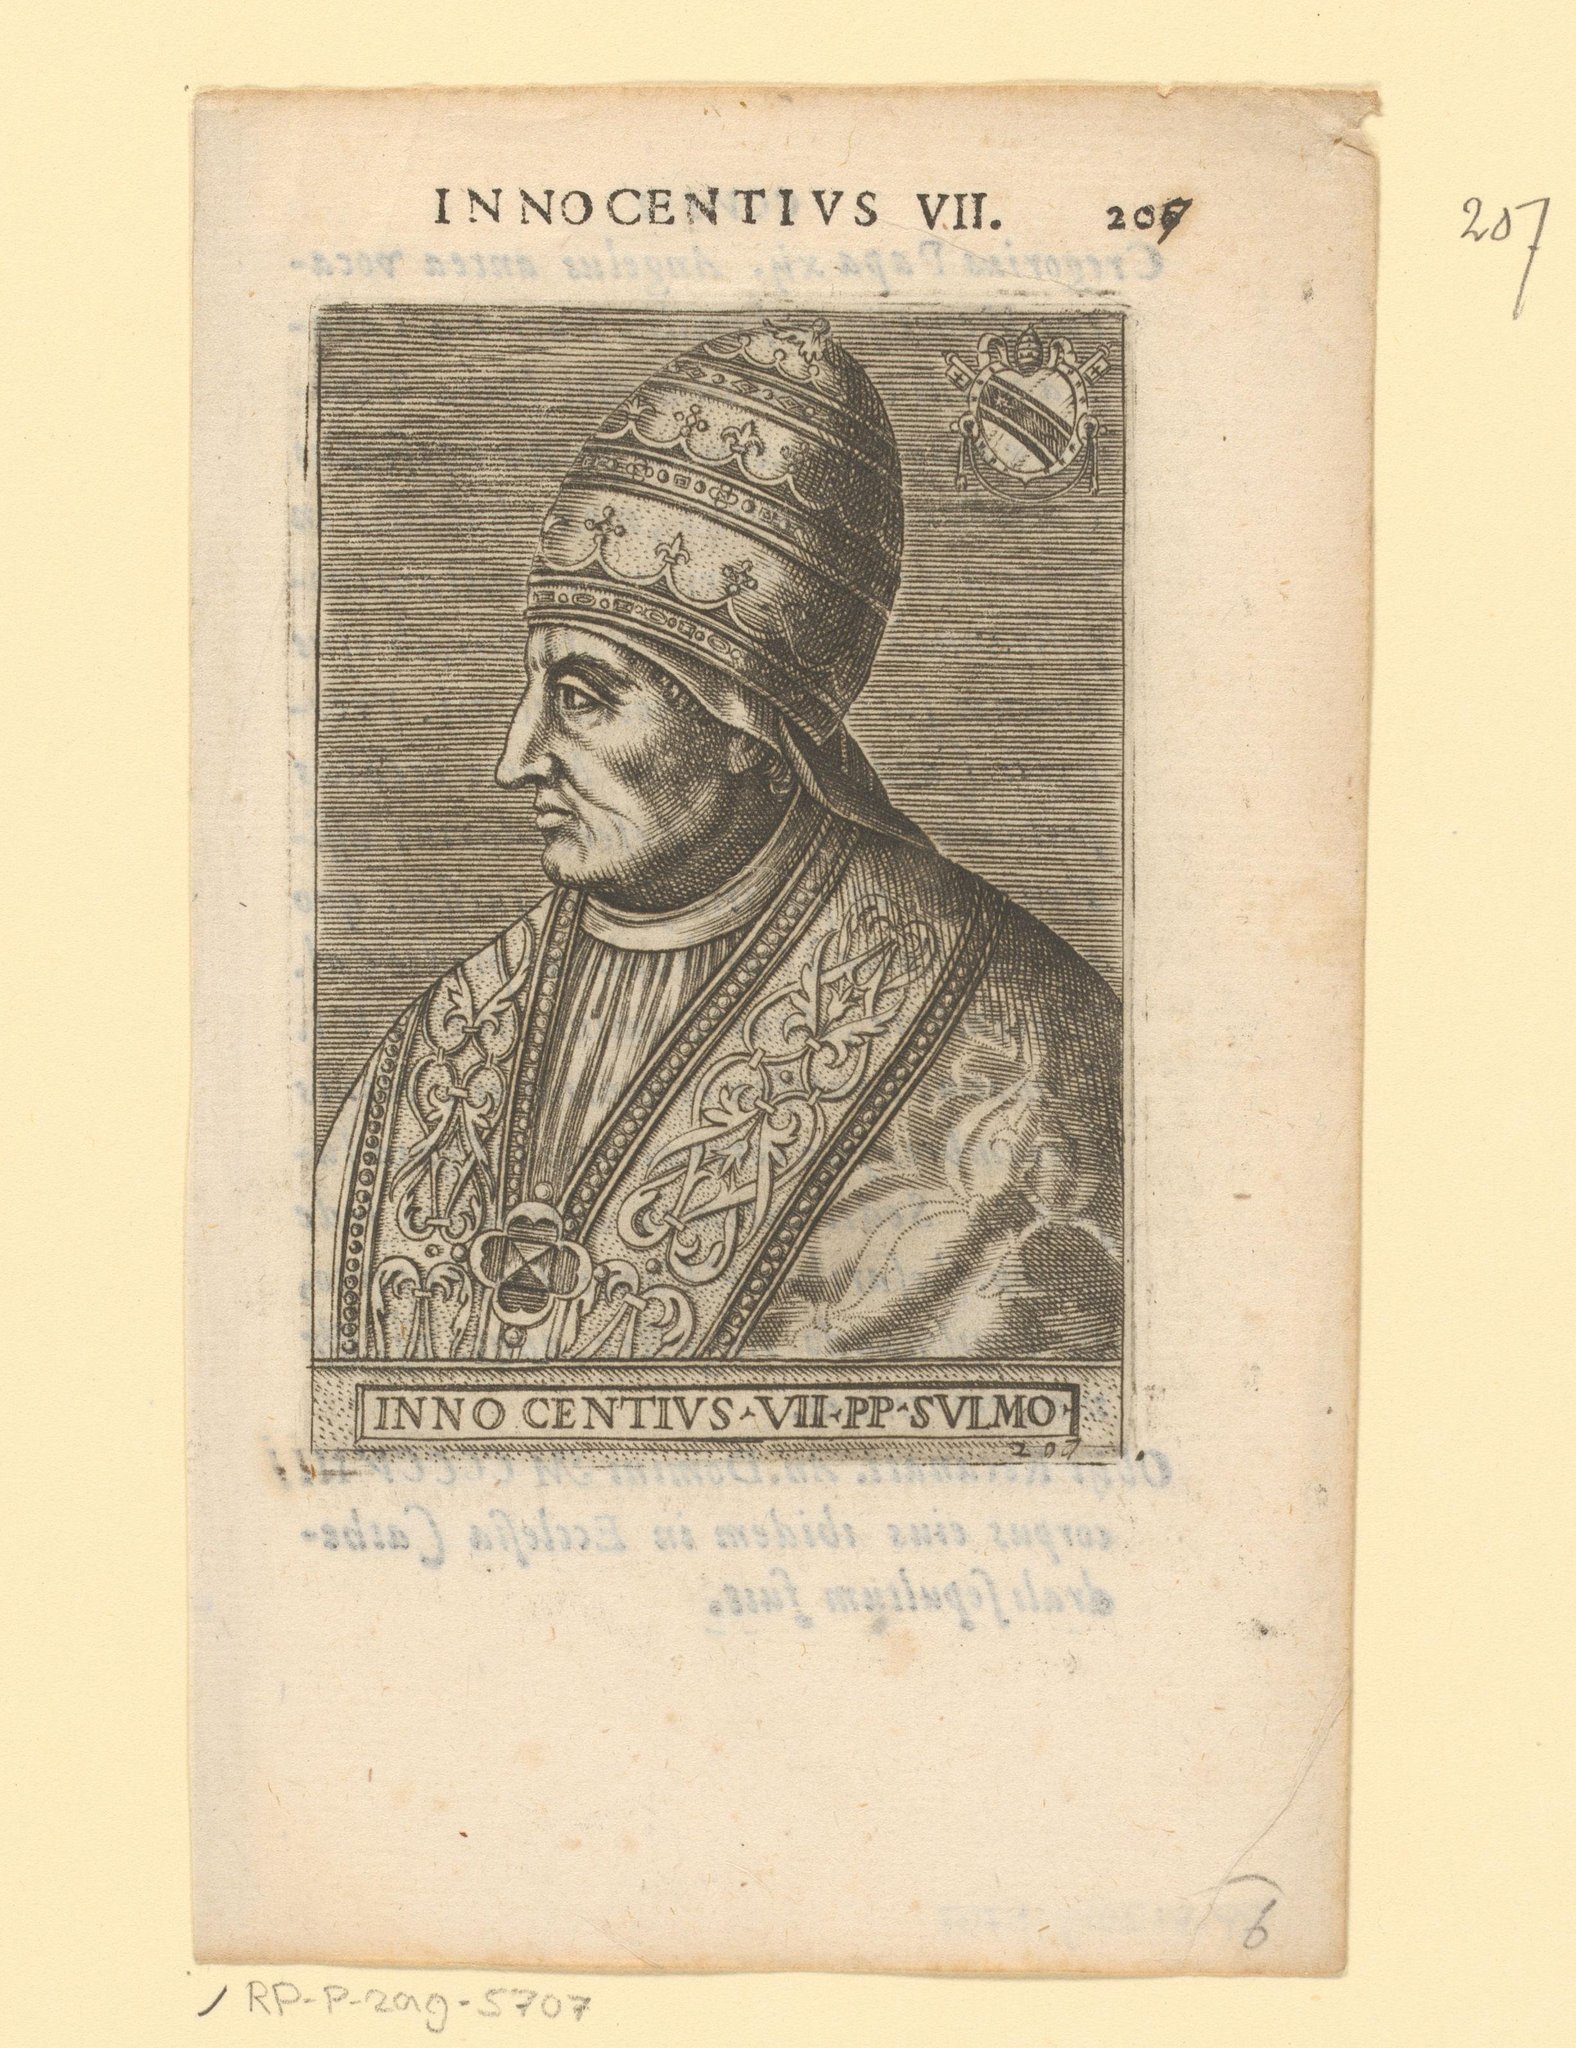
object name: book illustration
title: Innocentius VII PP Sulmo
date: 1595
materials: paper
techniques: engraving, letterpress printing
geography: rome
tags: historical persons, pope, armorial bearing, heraldry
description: Prent uit: Cavalieri, Giovanni Battista de'. Effigies pontificum romanorum cum eorum vitis (...). Rome: Bartolomeo Bonfadino, 1595. Prent voor het eerst verschenen in: Cavalieri, Giovanni Battista de'. Pontificum romanorum effigies (...). Rome: Domenico Basa en Francesco Zanetti, 1580. Prent ook gebruikt in latere publicaties.